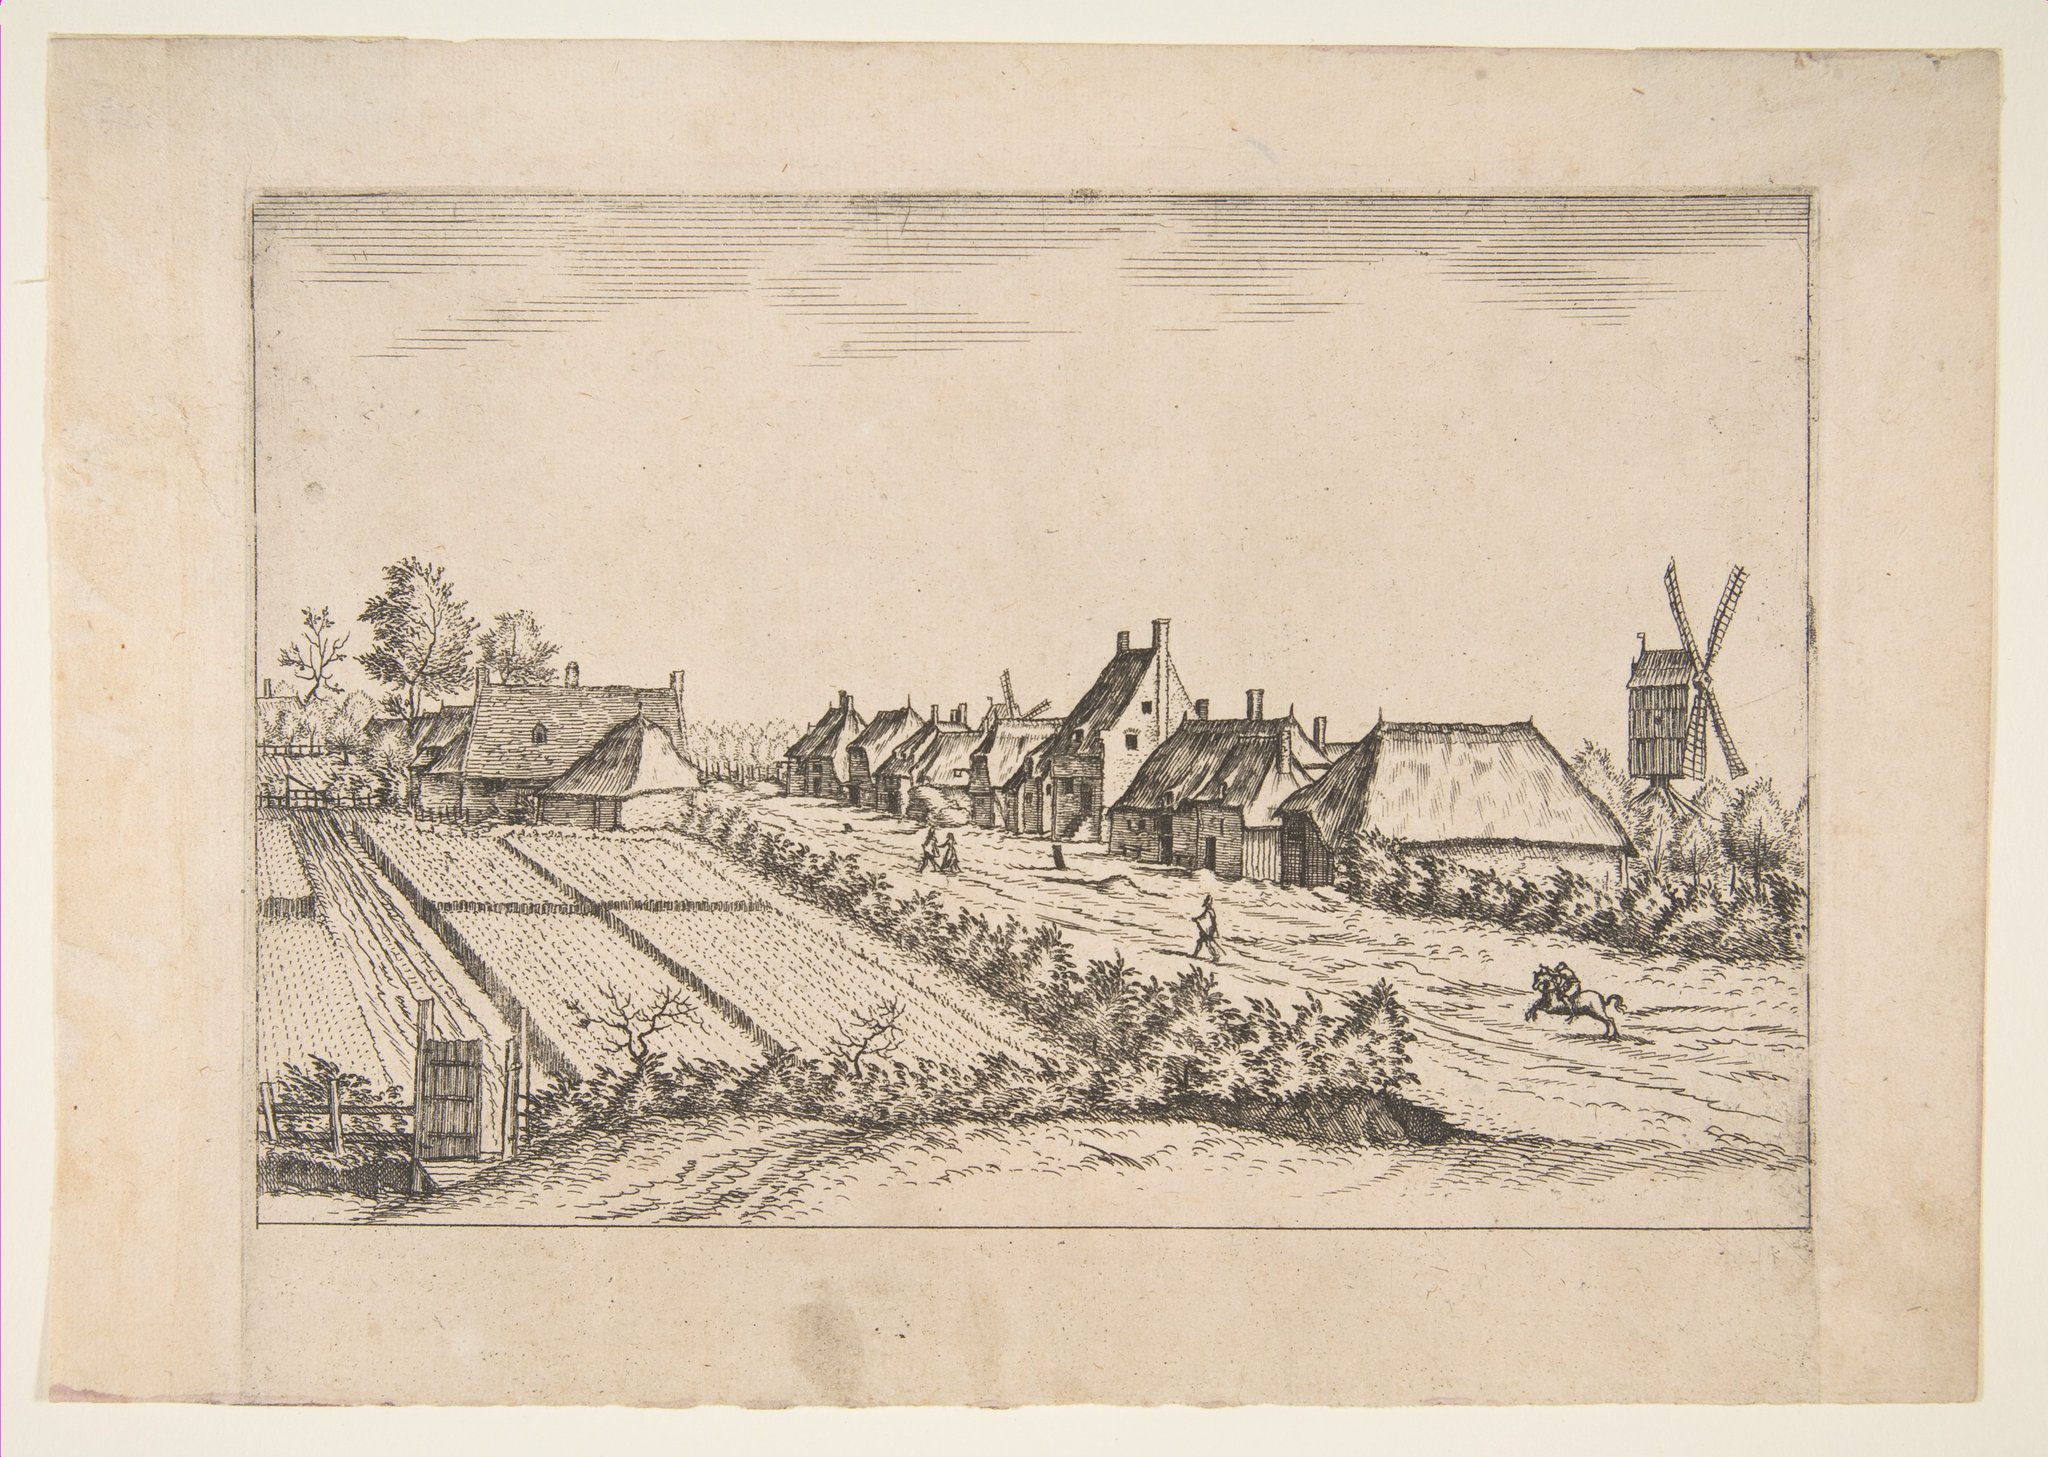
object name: print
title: Fields with a Village Road with Post Mill, from the series The Small Landscapes (Multifariarum Casularum)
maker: johannes van doetecum i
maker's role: artist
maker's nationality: netherlandish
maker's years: 1528-1605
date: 1559-1561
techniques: etching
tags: houses,windmills,villages,landscapes,trees